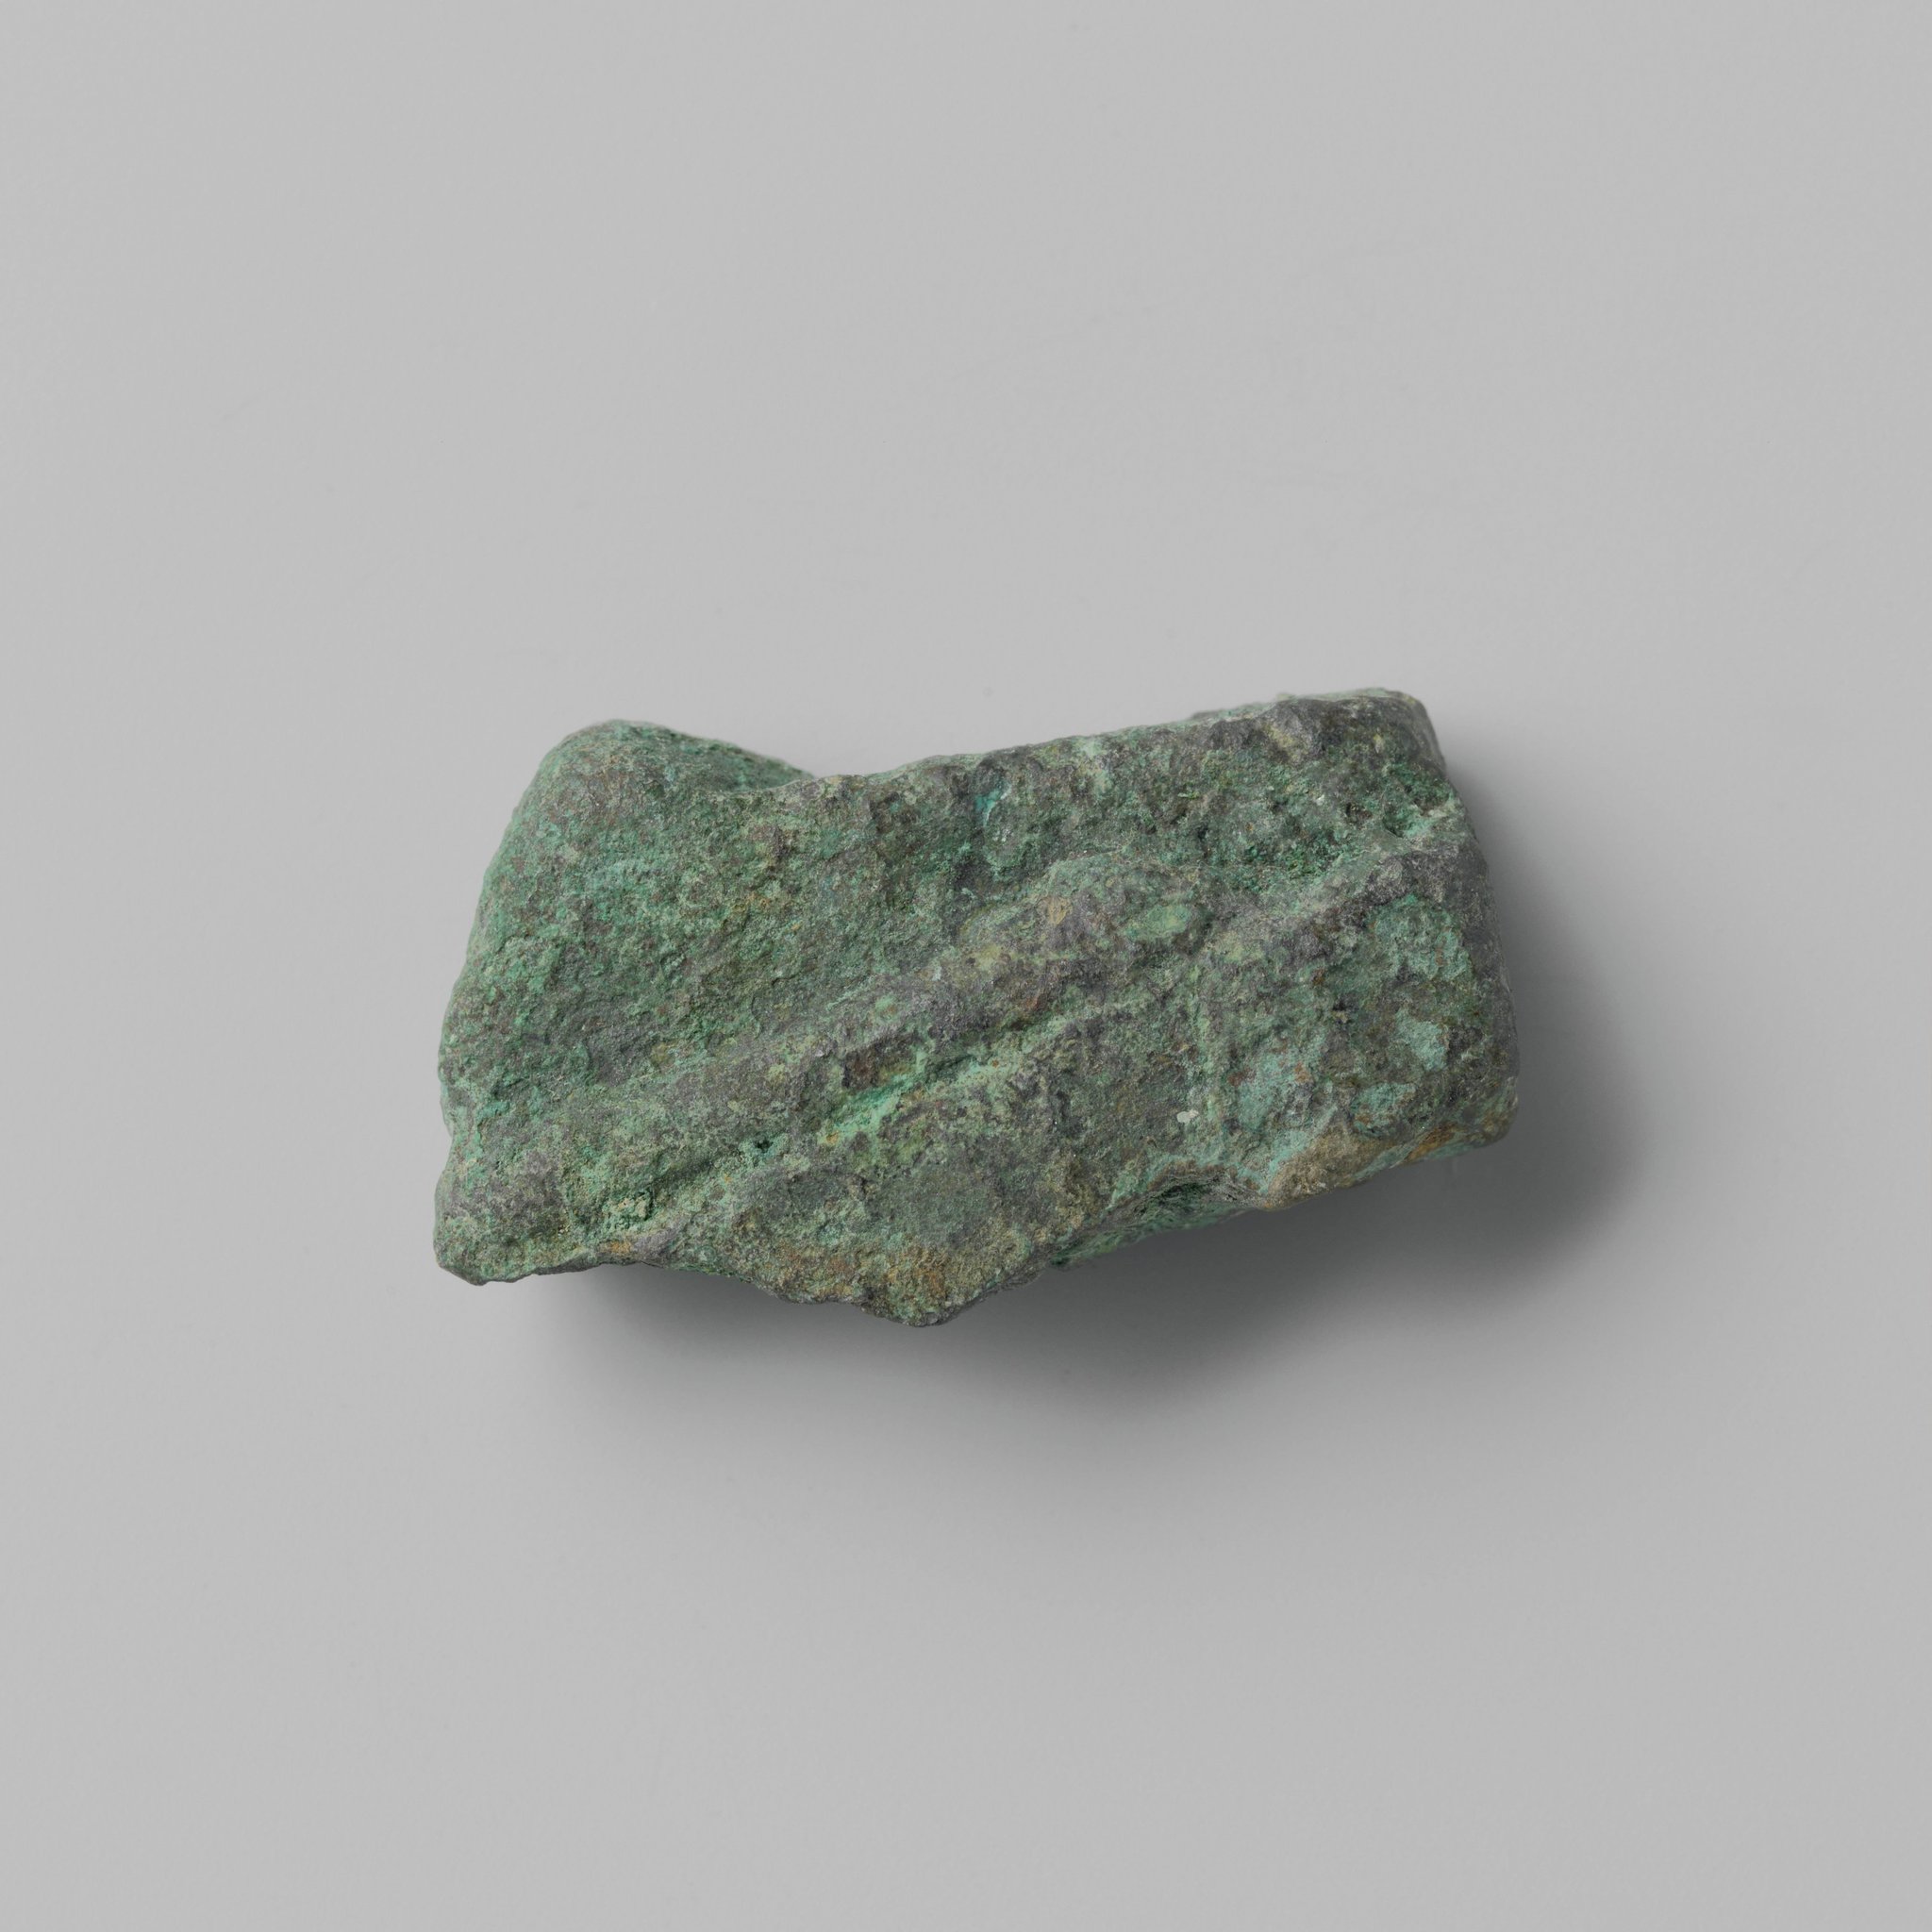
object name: percussion instrument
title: Fragment of a ship bell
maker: Anonymous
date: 1700-1743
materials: copper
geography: netherlands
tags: verenigde oostindische compagnie, hollandia (schip), annet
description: Acoustic, bell (ship's); fragment, sim. NG 1980-27H2954.